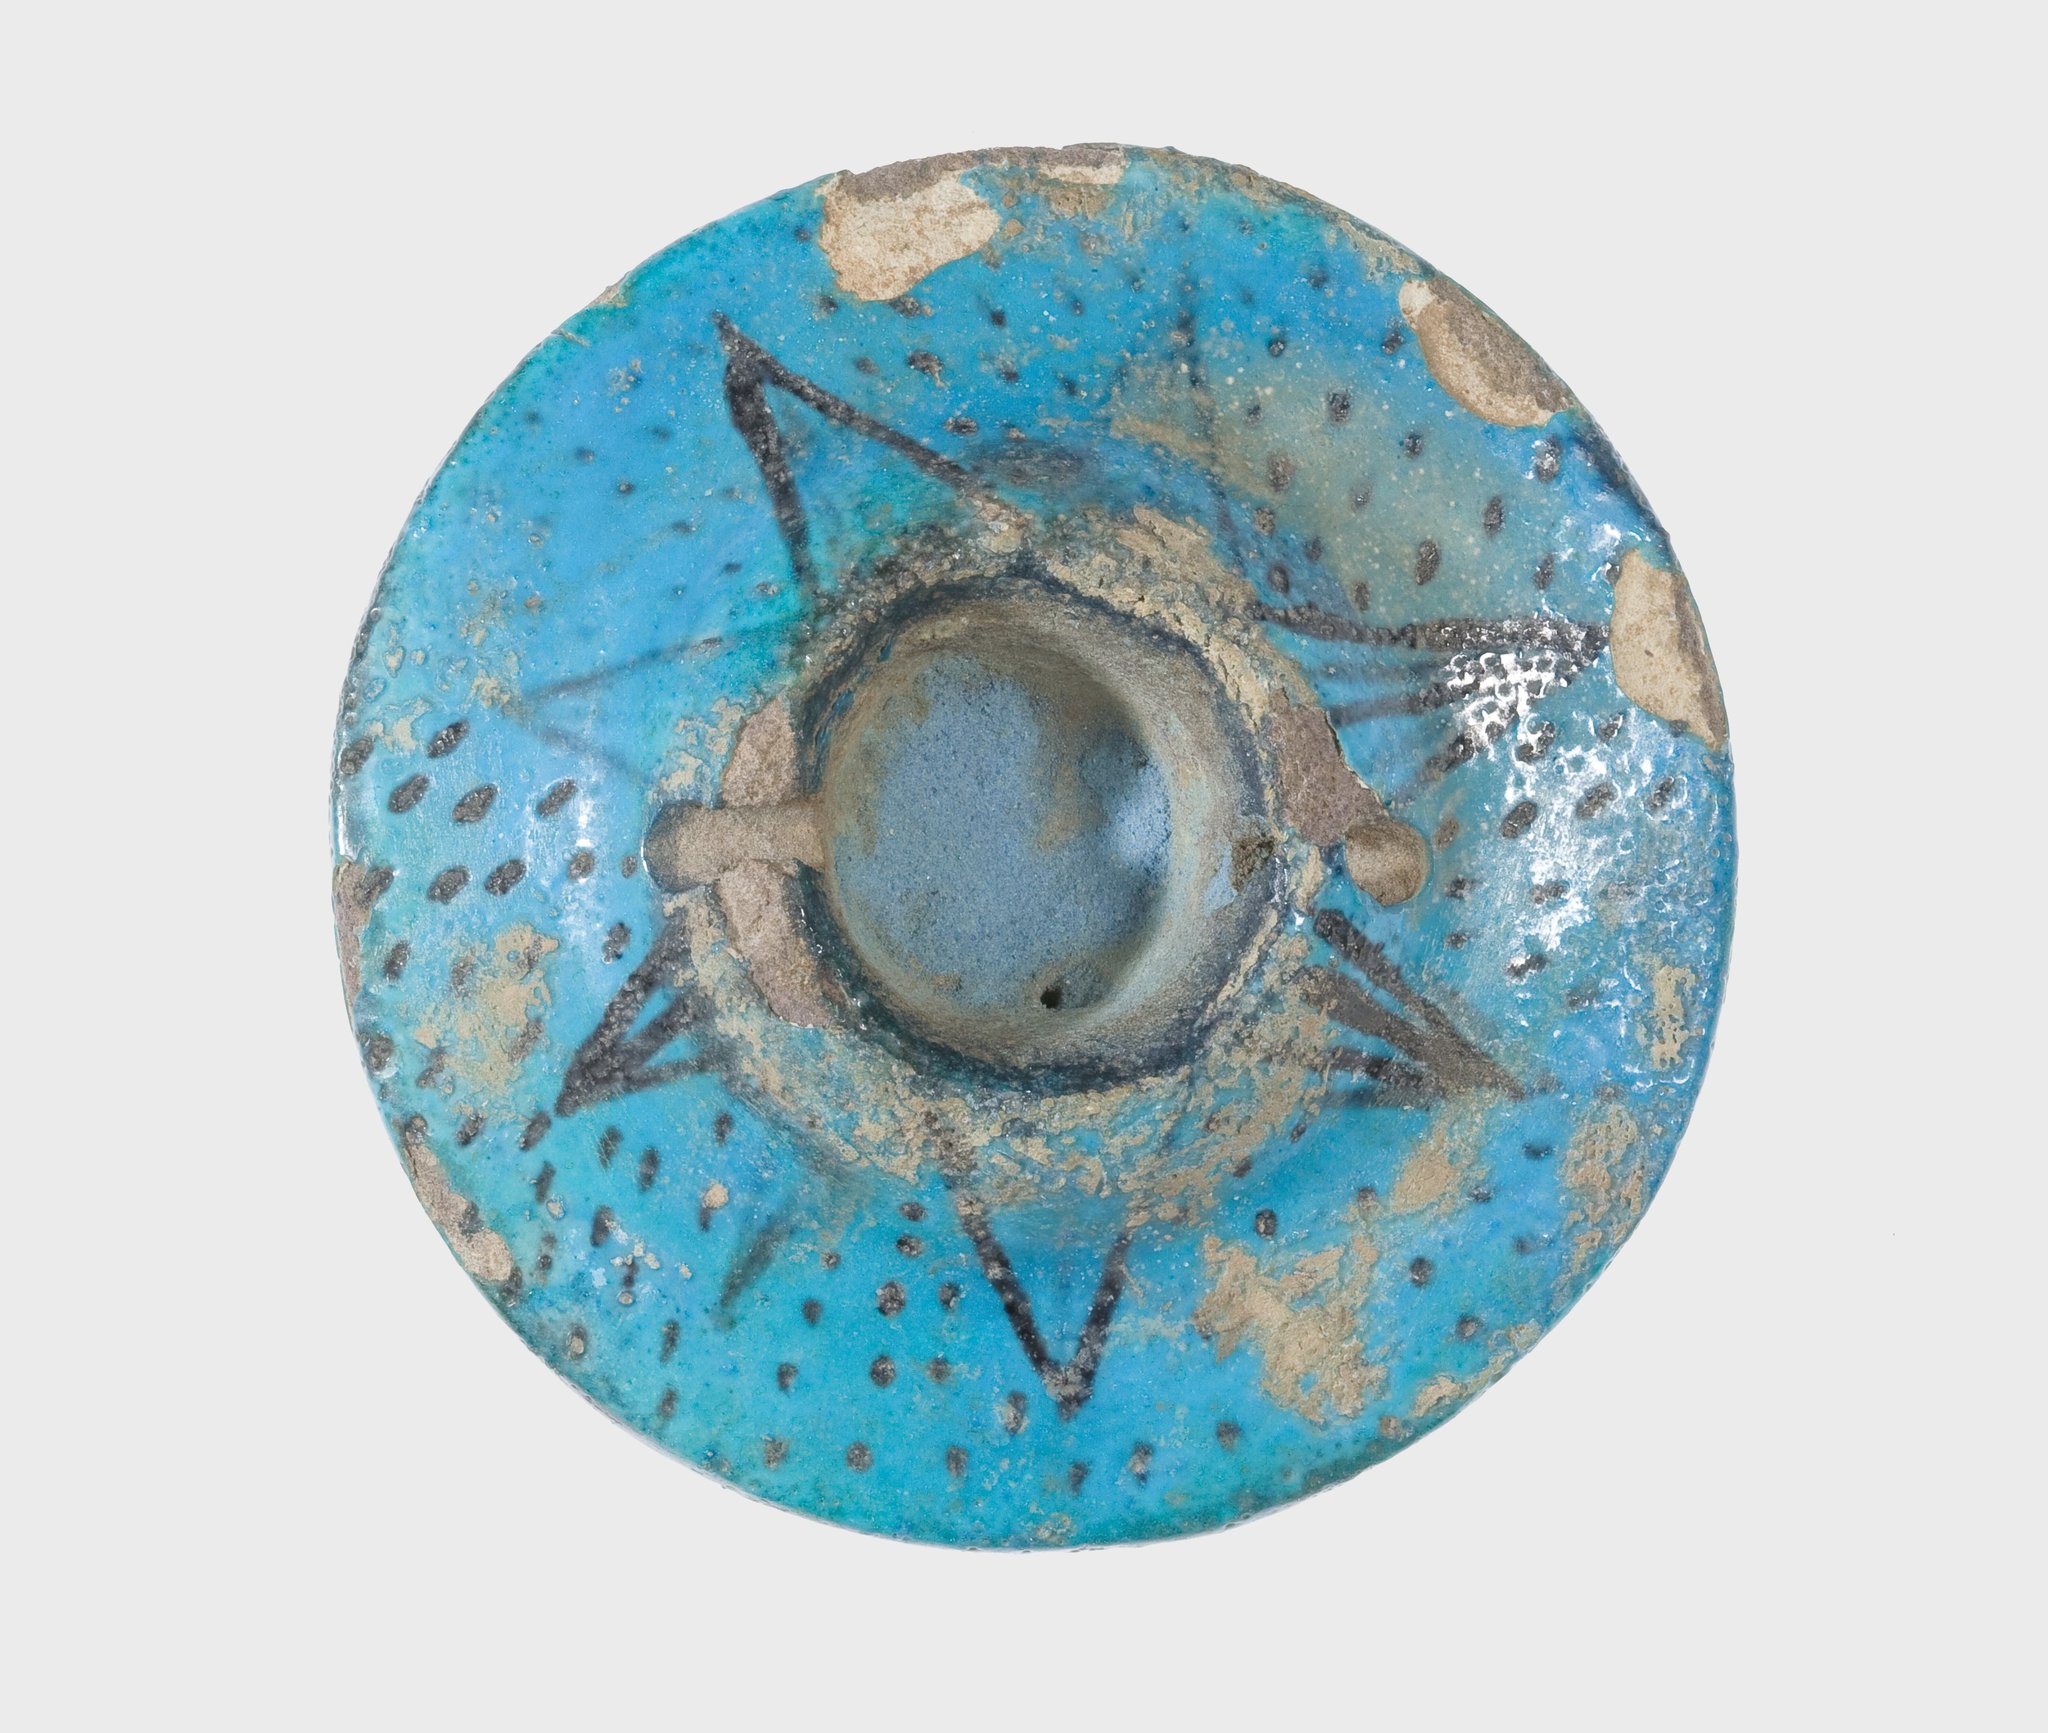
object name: jar with lid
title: Jar Lid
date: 1390-1352 BCE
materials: faience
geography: egypt